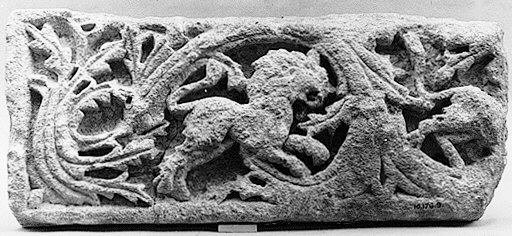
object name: fragment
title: Fragment of a Frieze with Scrolls and a Lion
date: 401-600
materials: limestone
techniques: carving, relief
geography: egypt